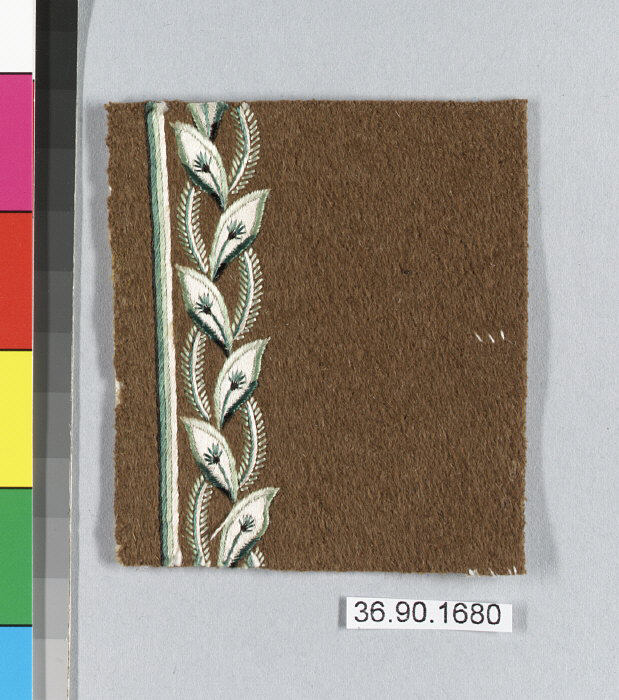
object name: sample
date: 1801-1833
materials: felt, silk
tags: leaves